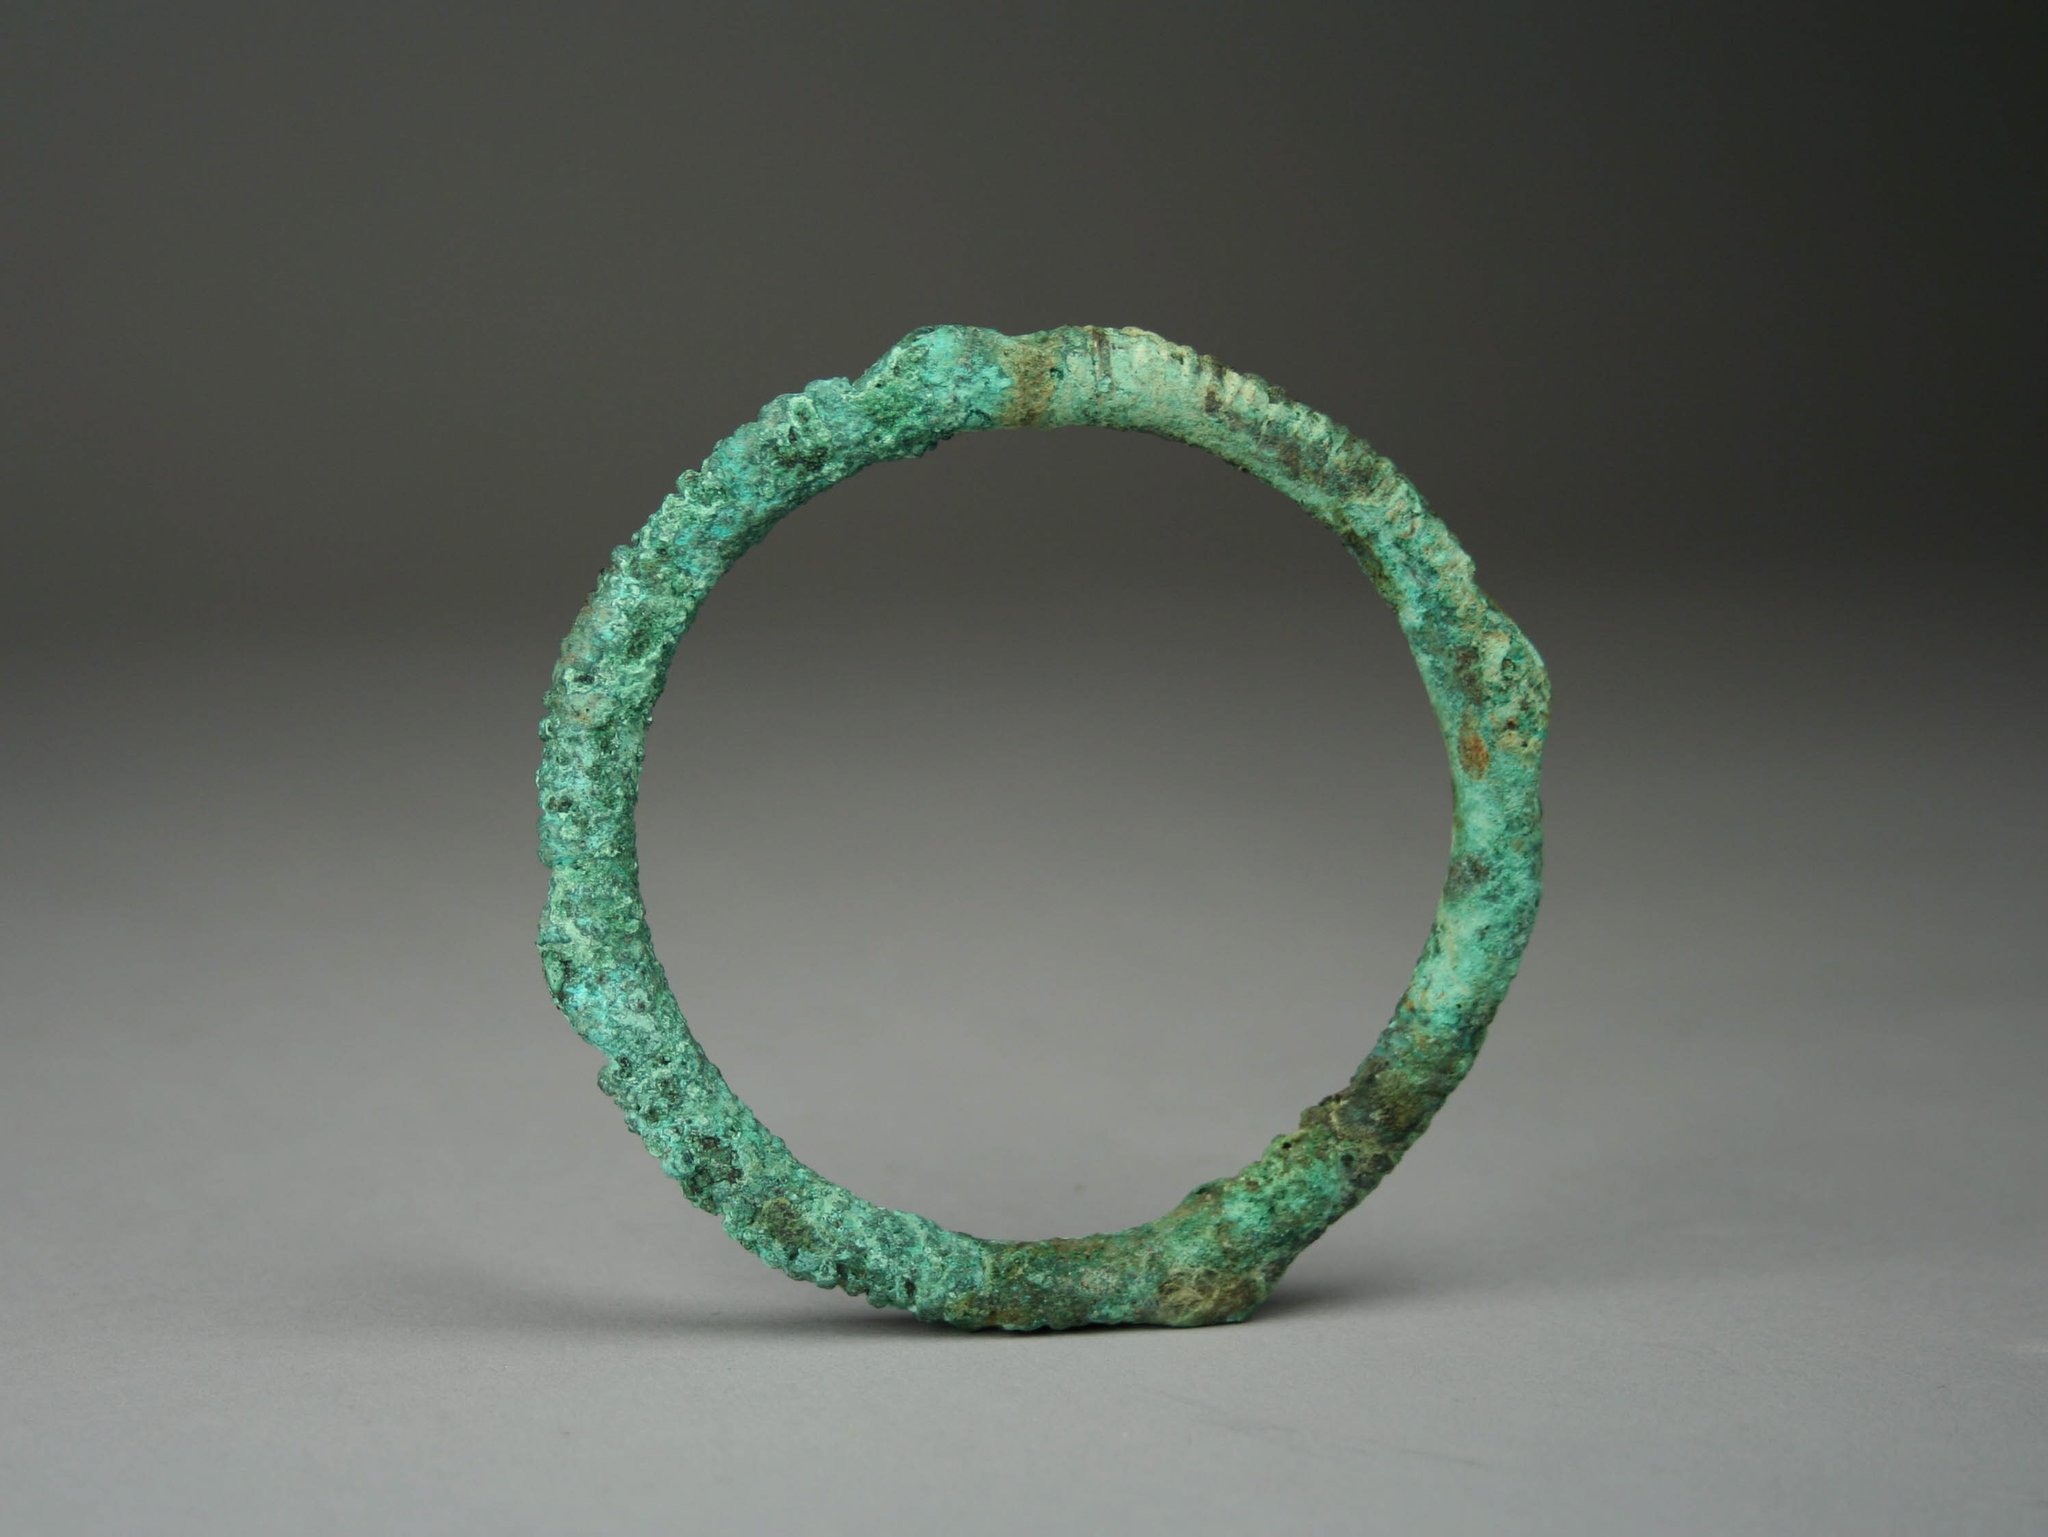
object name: bracelet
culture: middle niger civilization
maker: middle niger artist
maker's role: artist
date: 1401-1900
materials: bronze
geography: mali